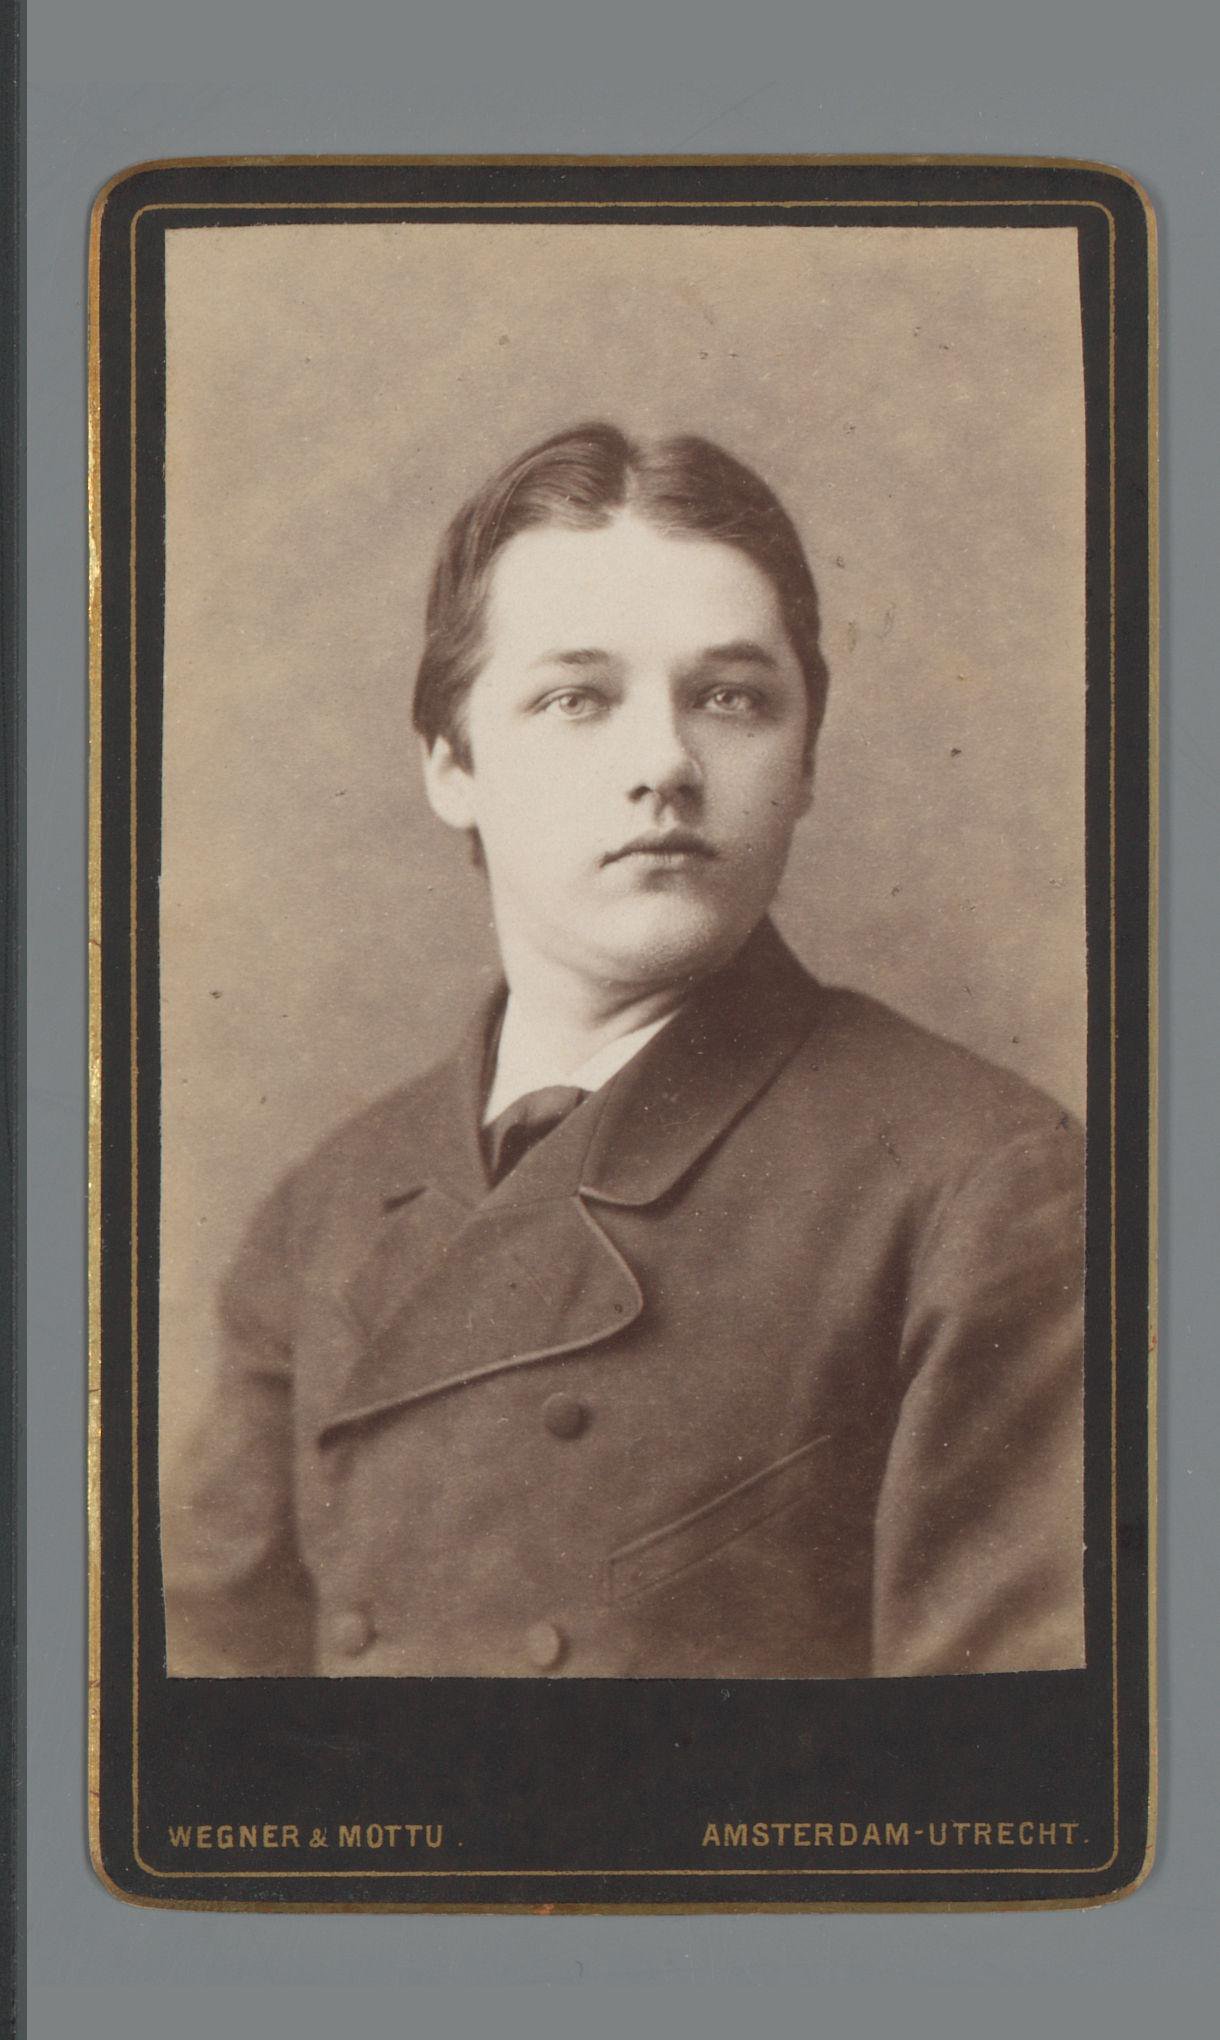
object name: photograph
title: Portret van Lucas Jonker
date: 1870-1900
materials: cardboard, photographic support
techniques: albumen print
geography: amsterdam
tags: historical persons, amsterdam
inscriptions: inscription: ‘L. Jonker jr.’, workshop stamp: ‘Photographisch Artistisch Atelier van/ Wegner & Mottu/ Amsterdam, Rokin over de Bank 138/ Utrecht, Hamburgerstraat, F 237’